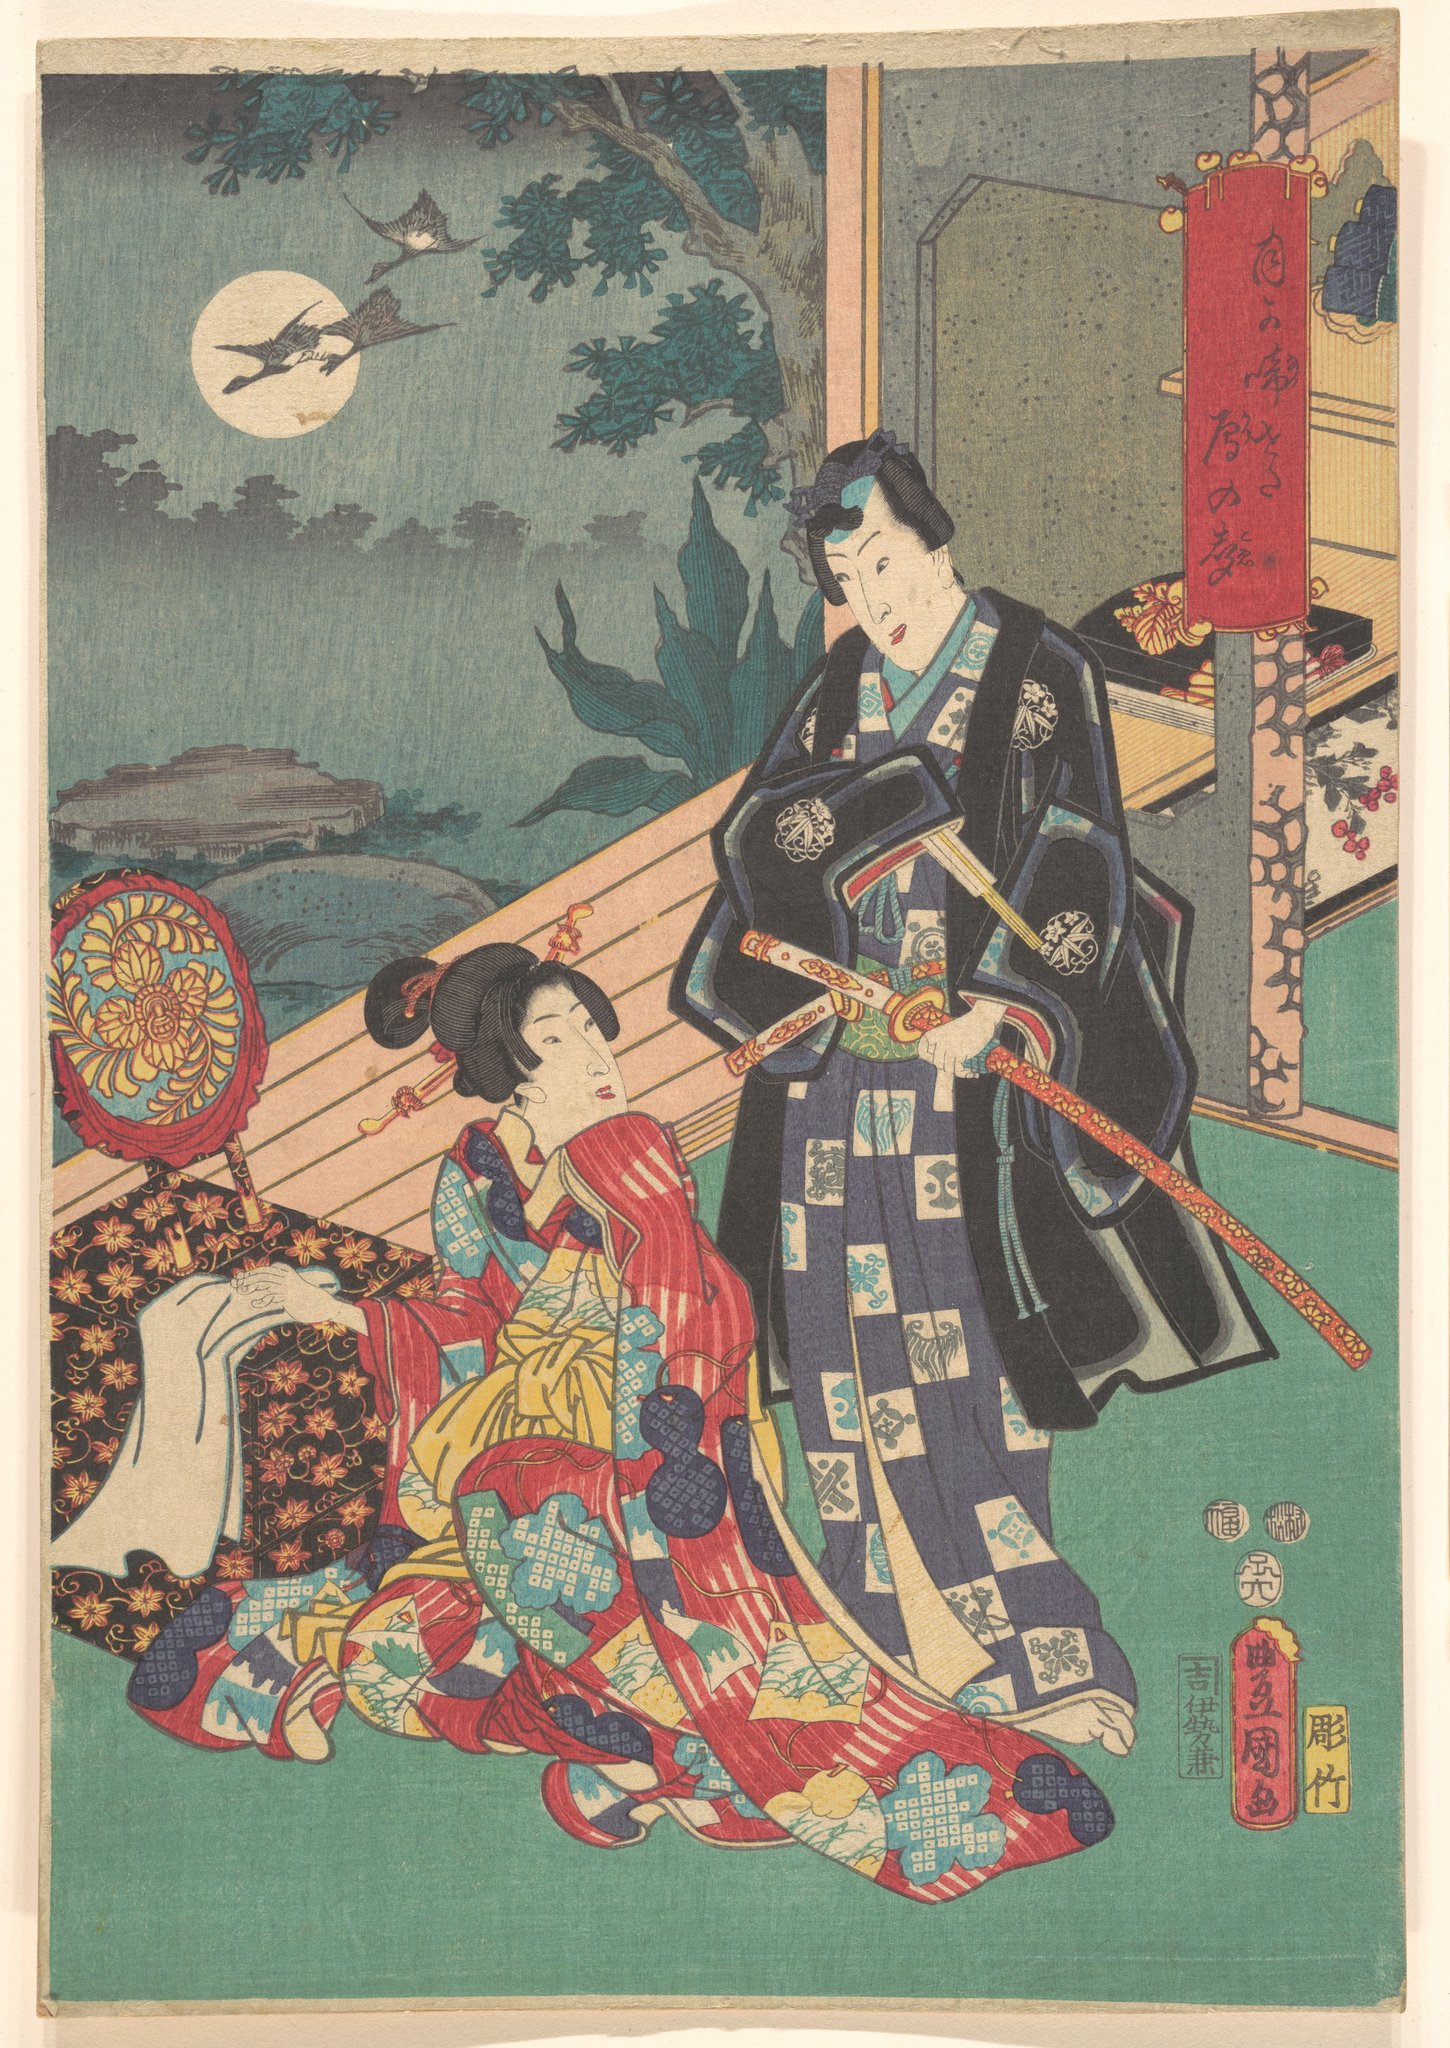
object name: print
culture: japanese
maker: utagawa kunisada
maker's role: artist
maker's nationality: japanese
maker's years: 1786-1864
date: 1786-1854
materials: ink, paper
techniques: woodblock print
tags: swords,men,women,moon,trees